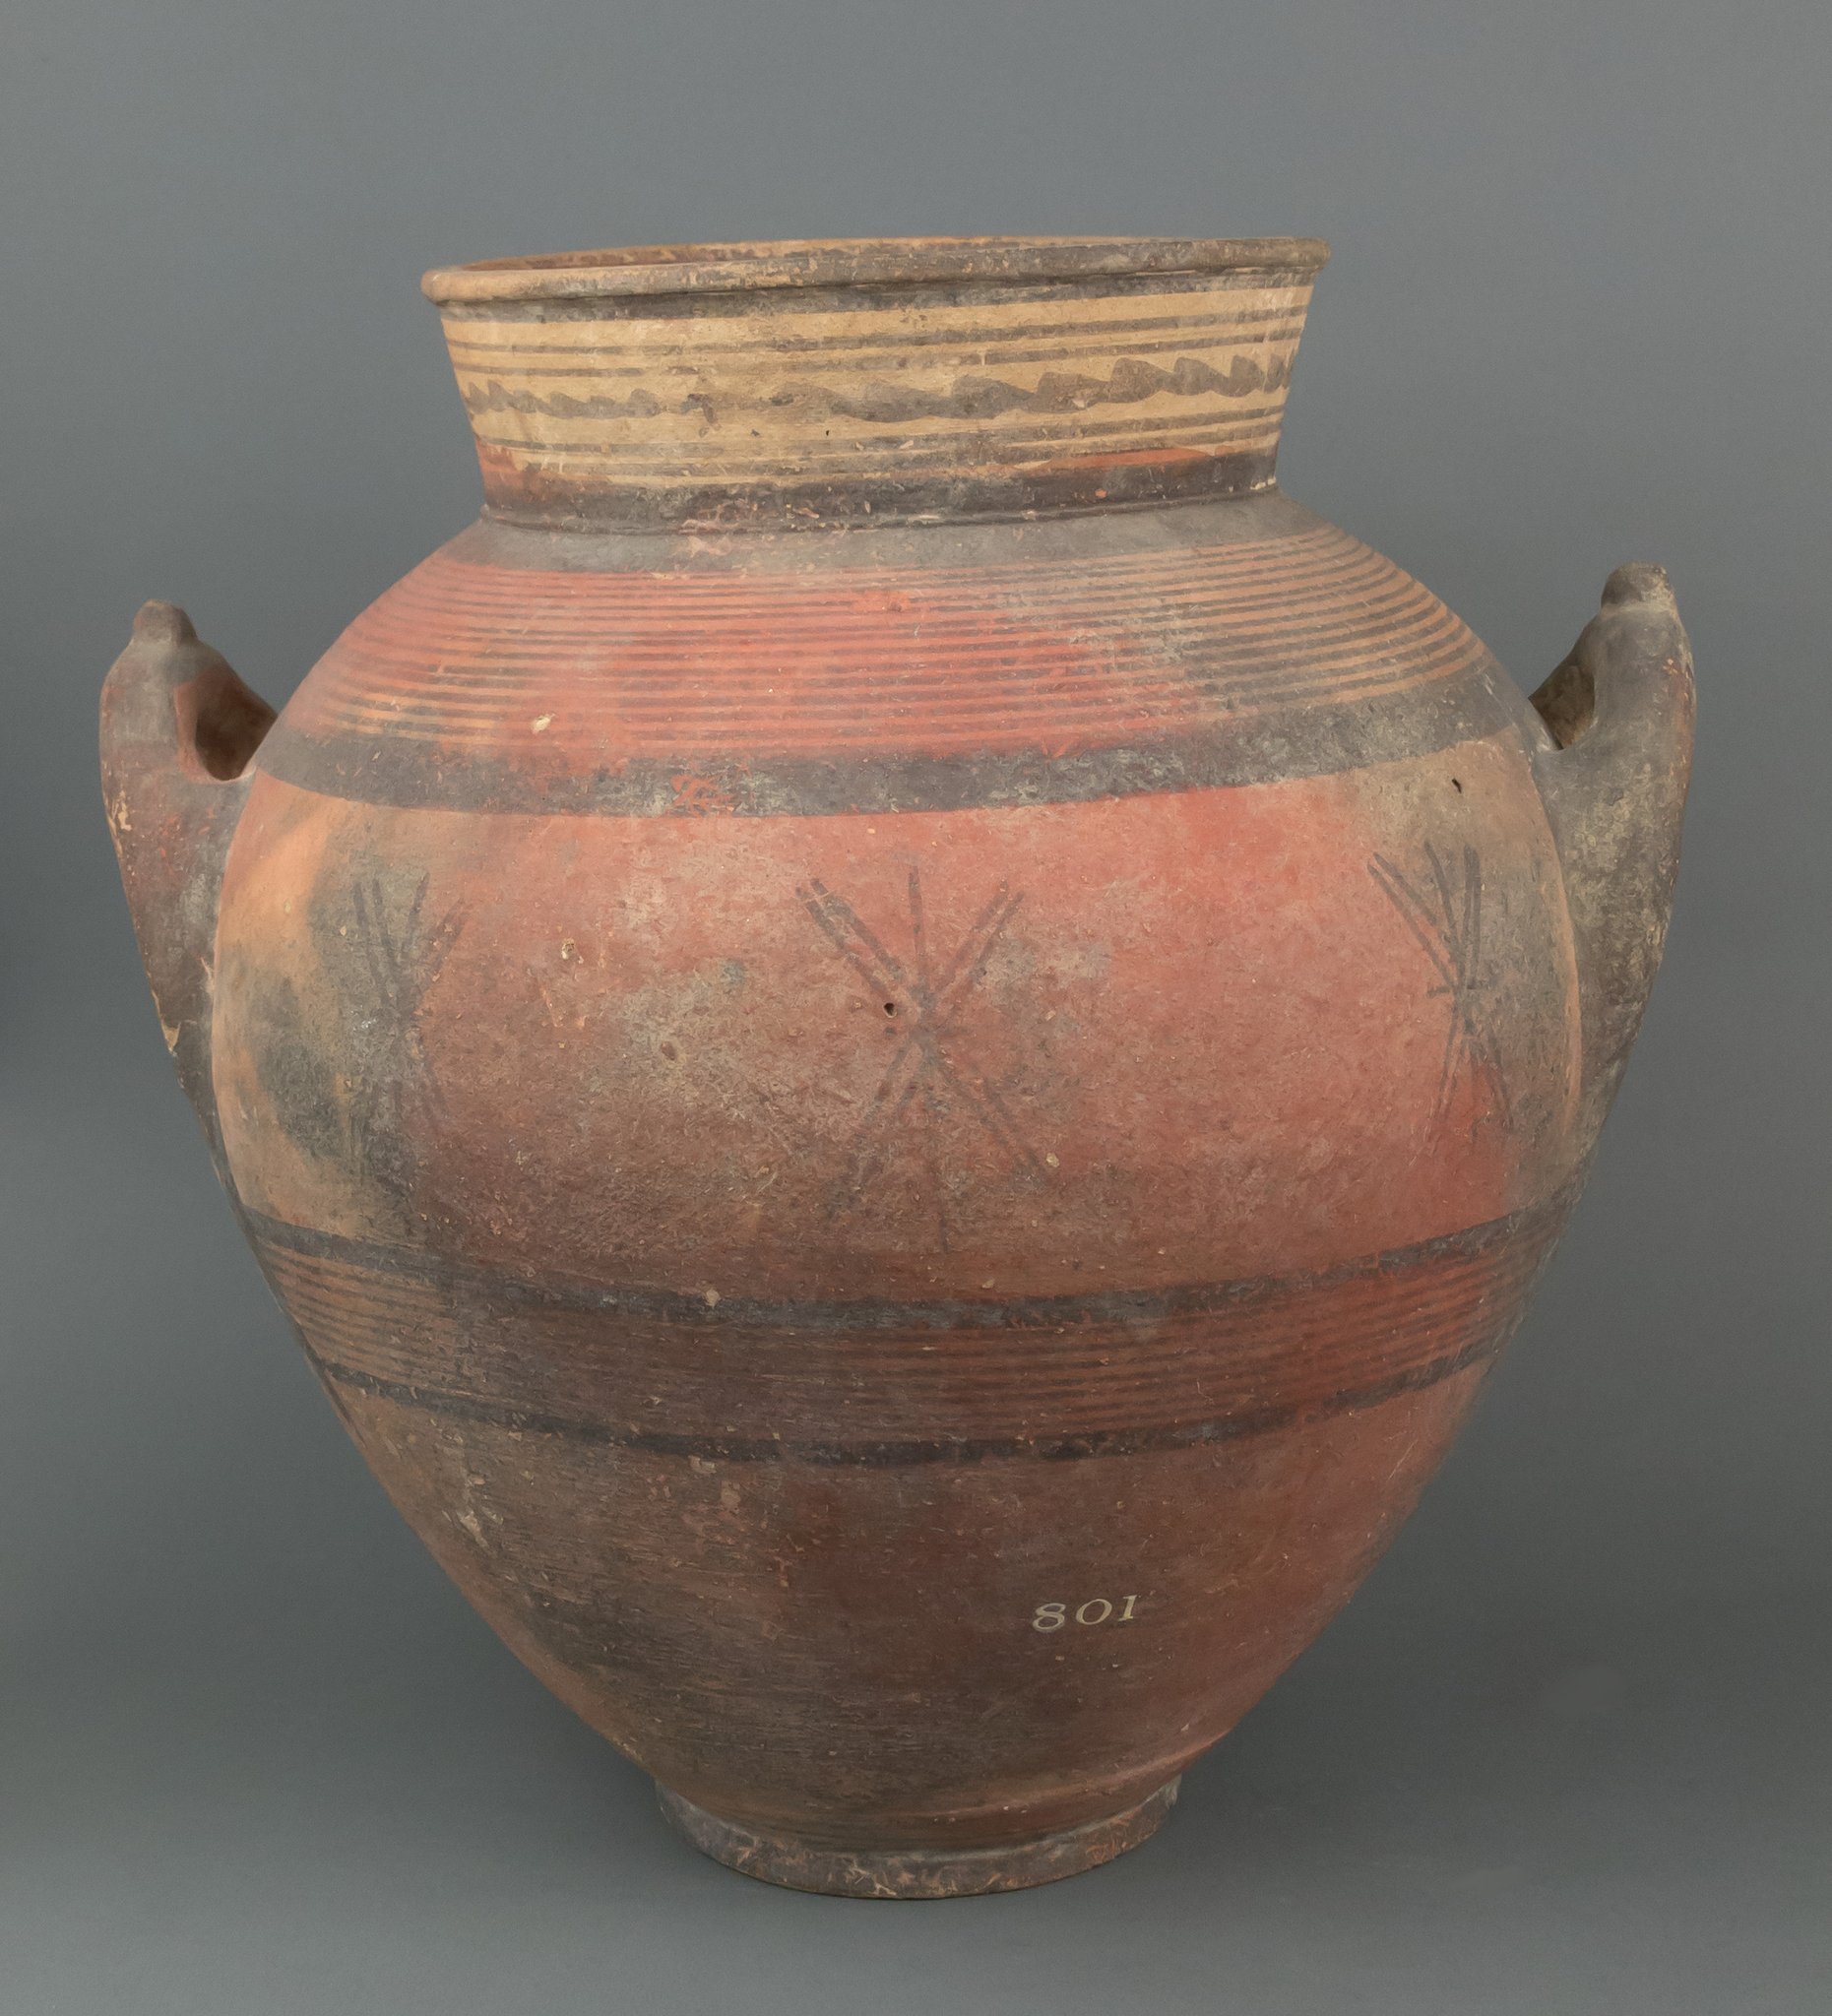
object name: amphora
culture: cypriot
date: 750-480 BCE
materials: terracotta